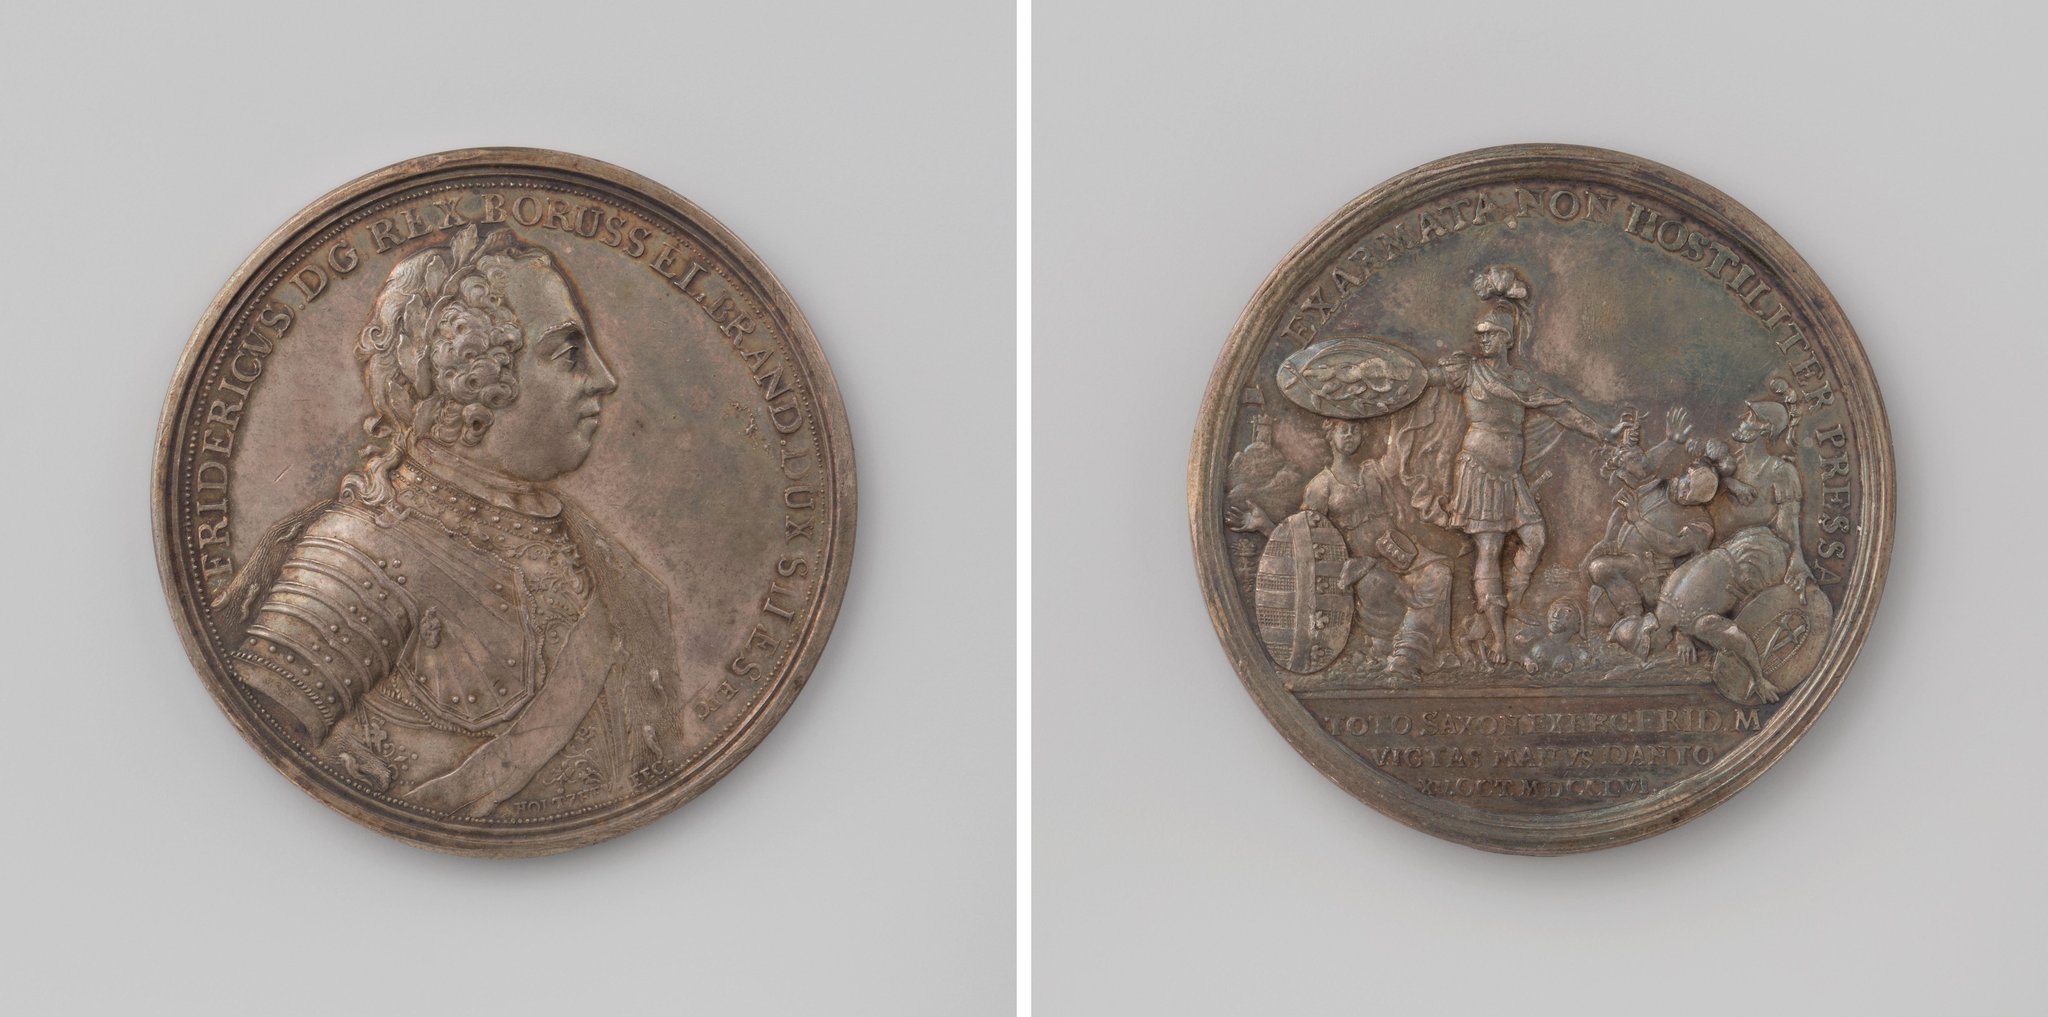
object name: history medal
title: Overgave van het Saksische leger aan Frederik II van Pruisen bij Pirna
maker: johan george holtzhey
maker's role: mintmaster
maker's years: 1726-1808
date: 1756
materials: silver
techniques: striking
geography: amsterdam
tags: berlin, frederick ii (king of prussia)